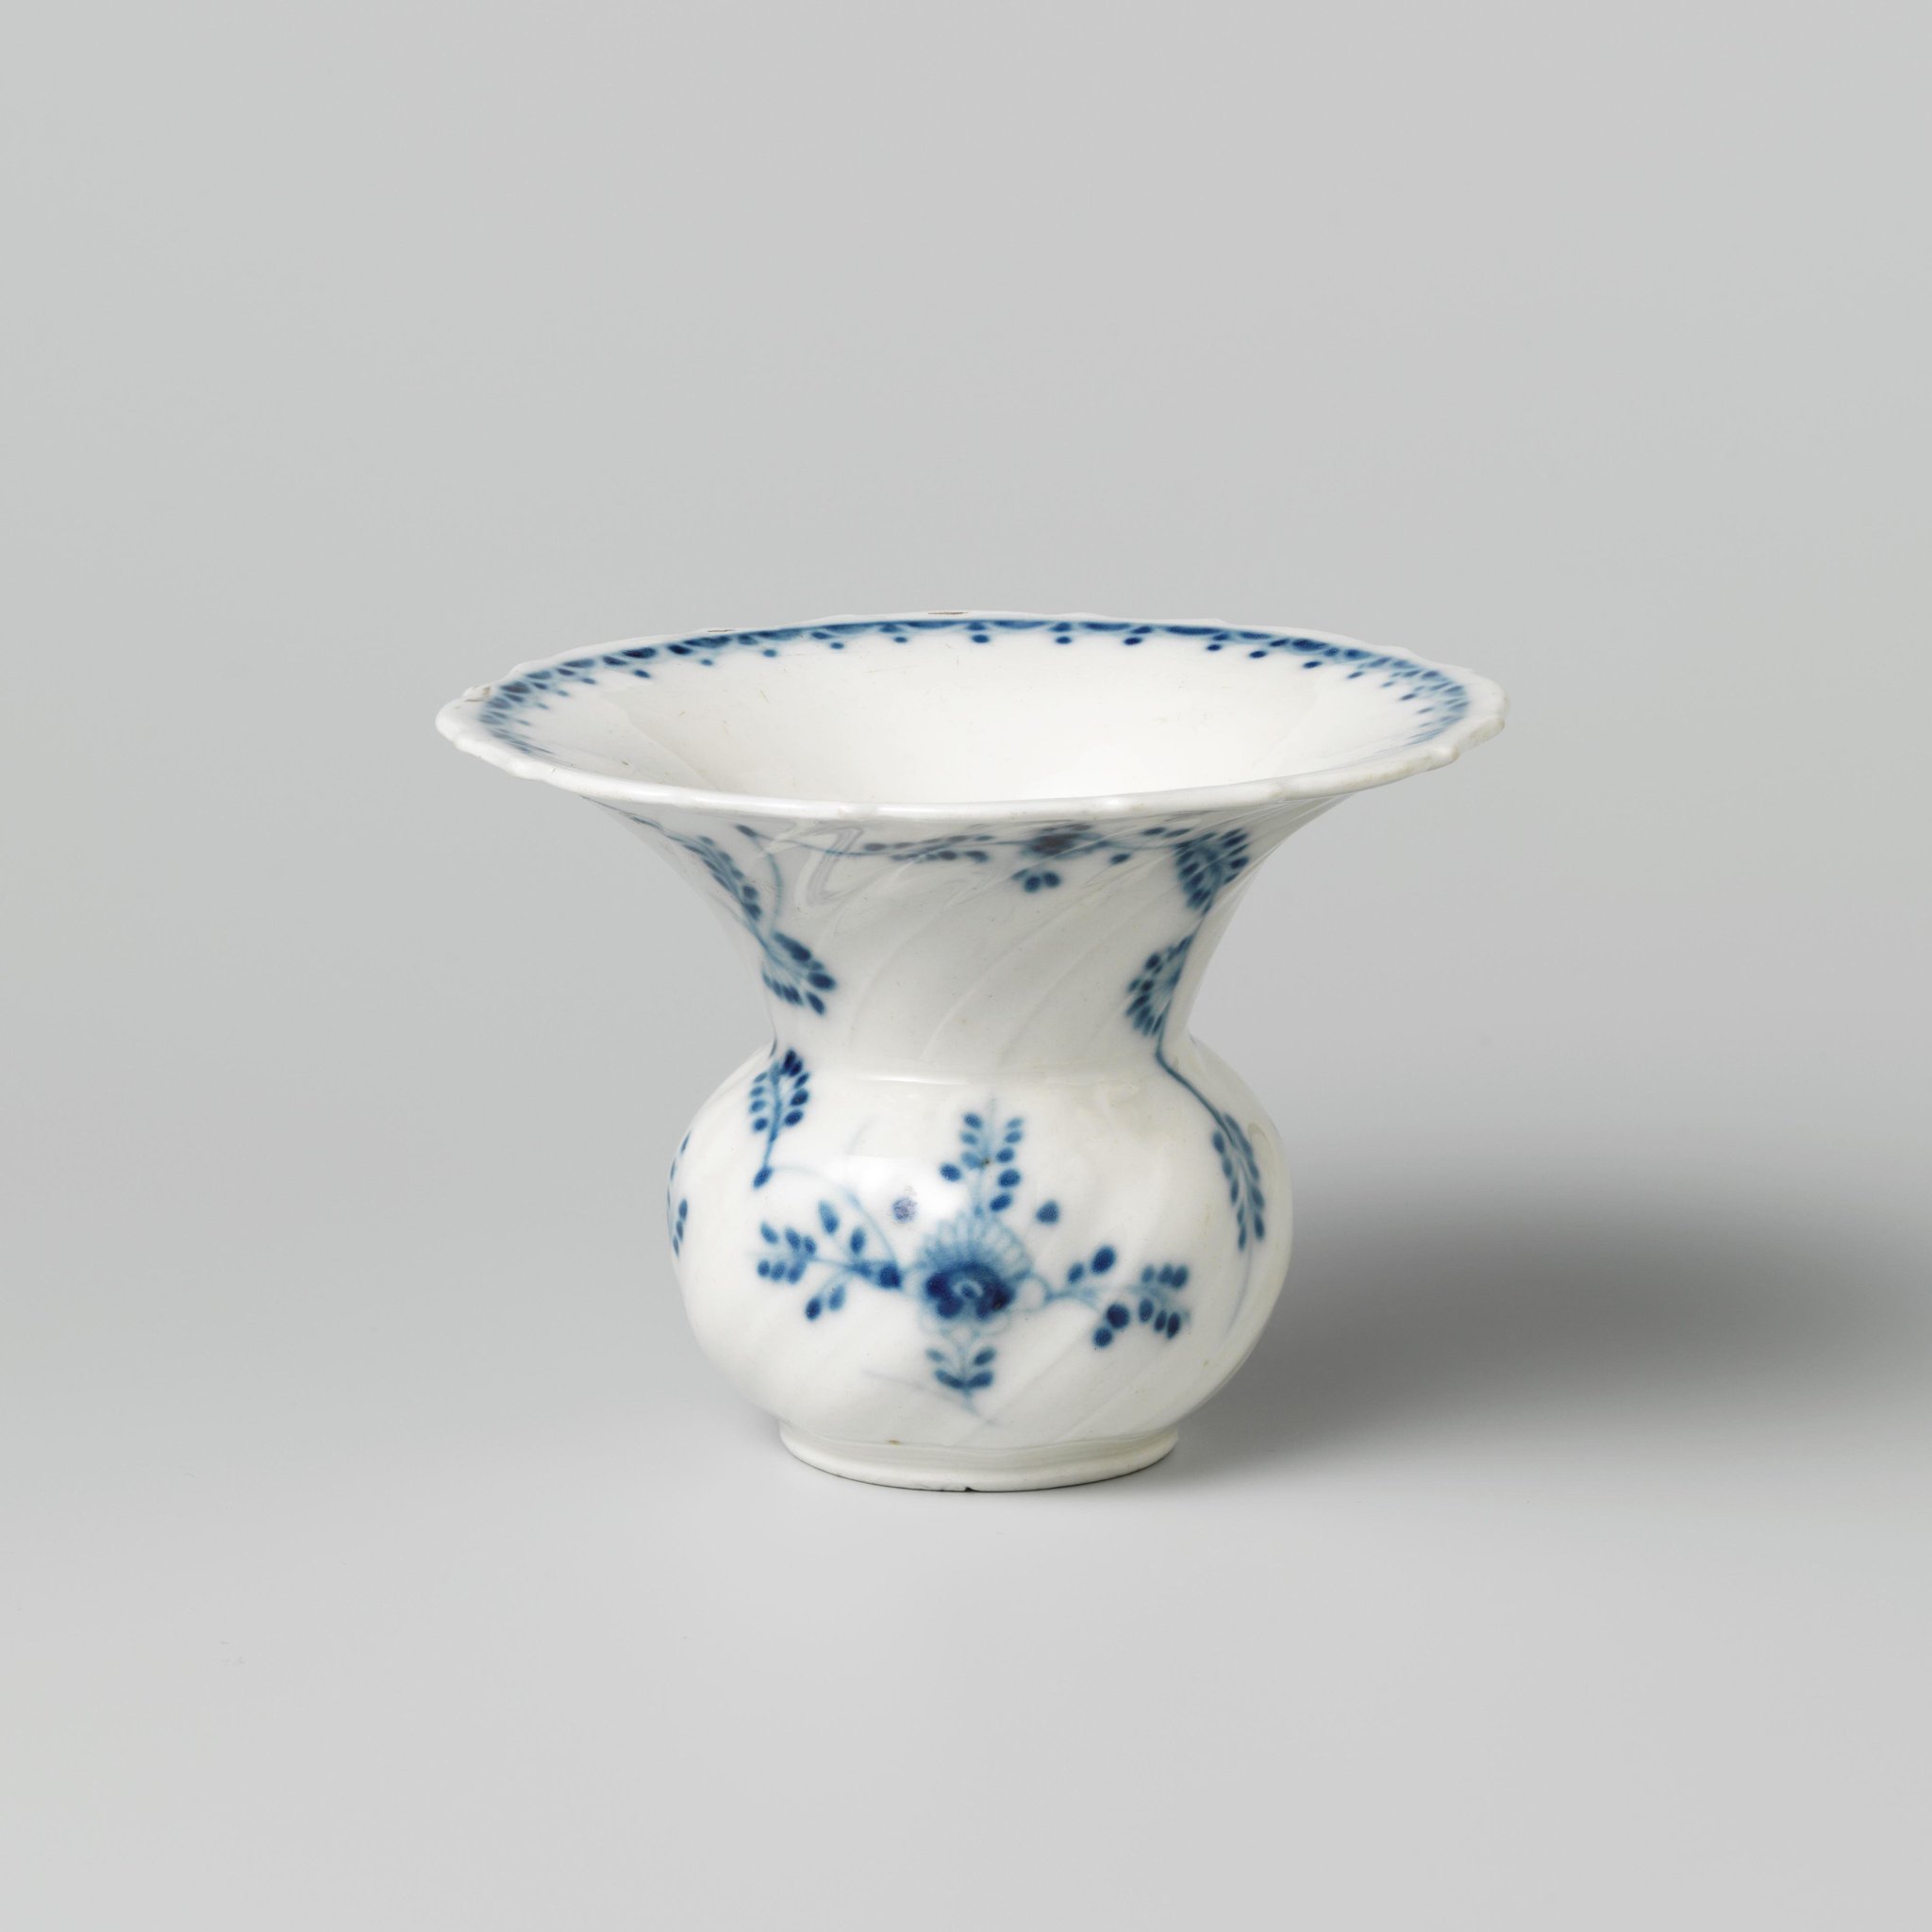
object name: spittoon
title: Kwispedoor met getorste ribben in reliëf, beschilderd met bloemtakken en bloem- en bladslingers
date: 1778-1782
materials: porcelain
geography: loosdrecht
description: Cuspidor. Porcelain, decorated in underglaze blue. Loosdrecht, c. 1778 -1 782. Factory of Joannes de Mol.